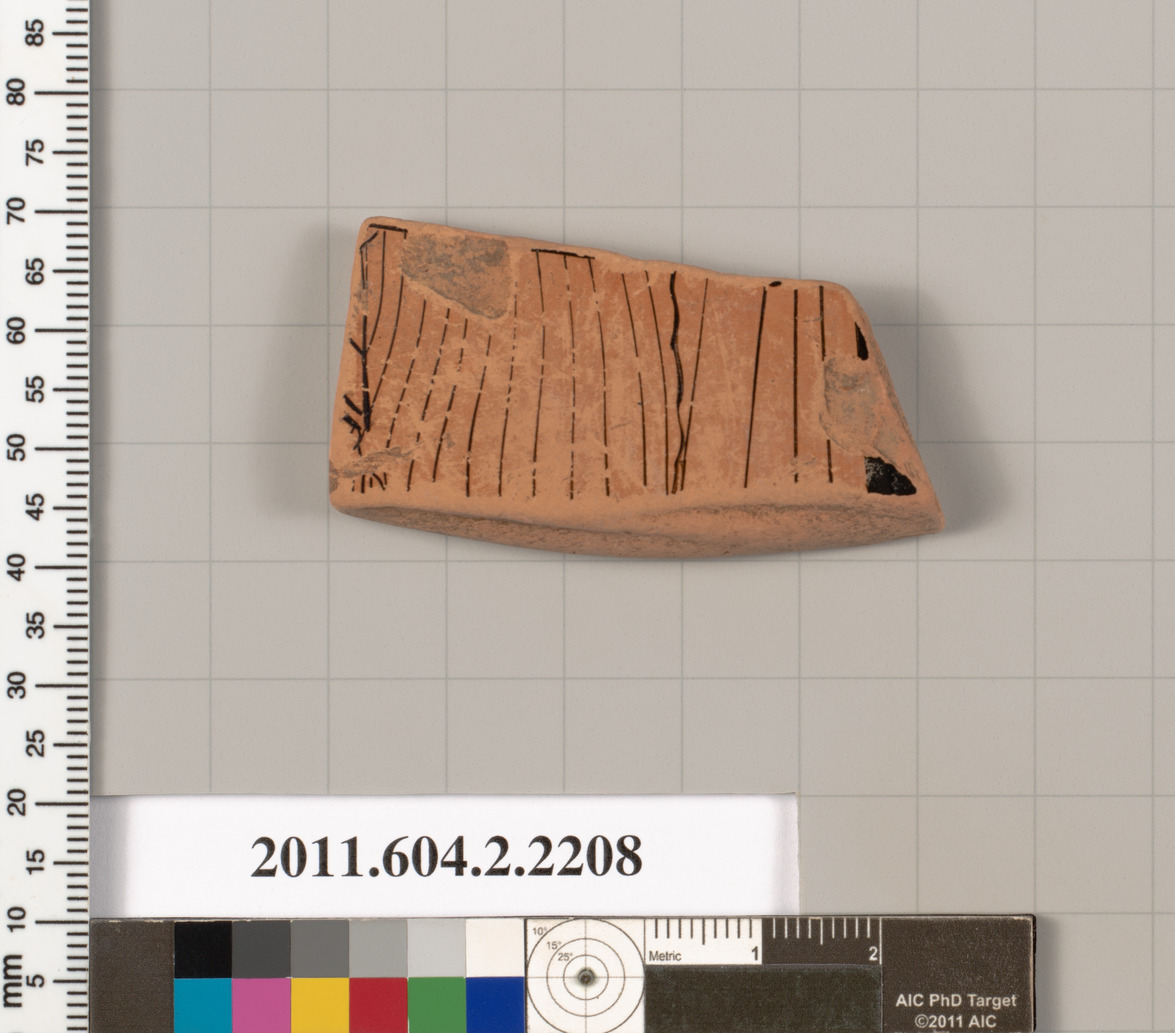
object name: pot fragment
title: Terracotta fragment of a pot; unglazed on the inside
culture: greek, attic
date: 475-451 BCE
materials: terracotta